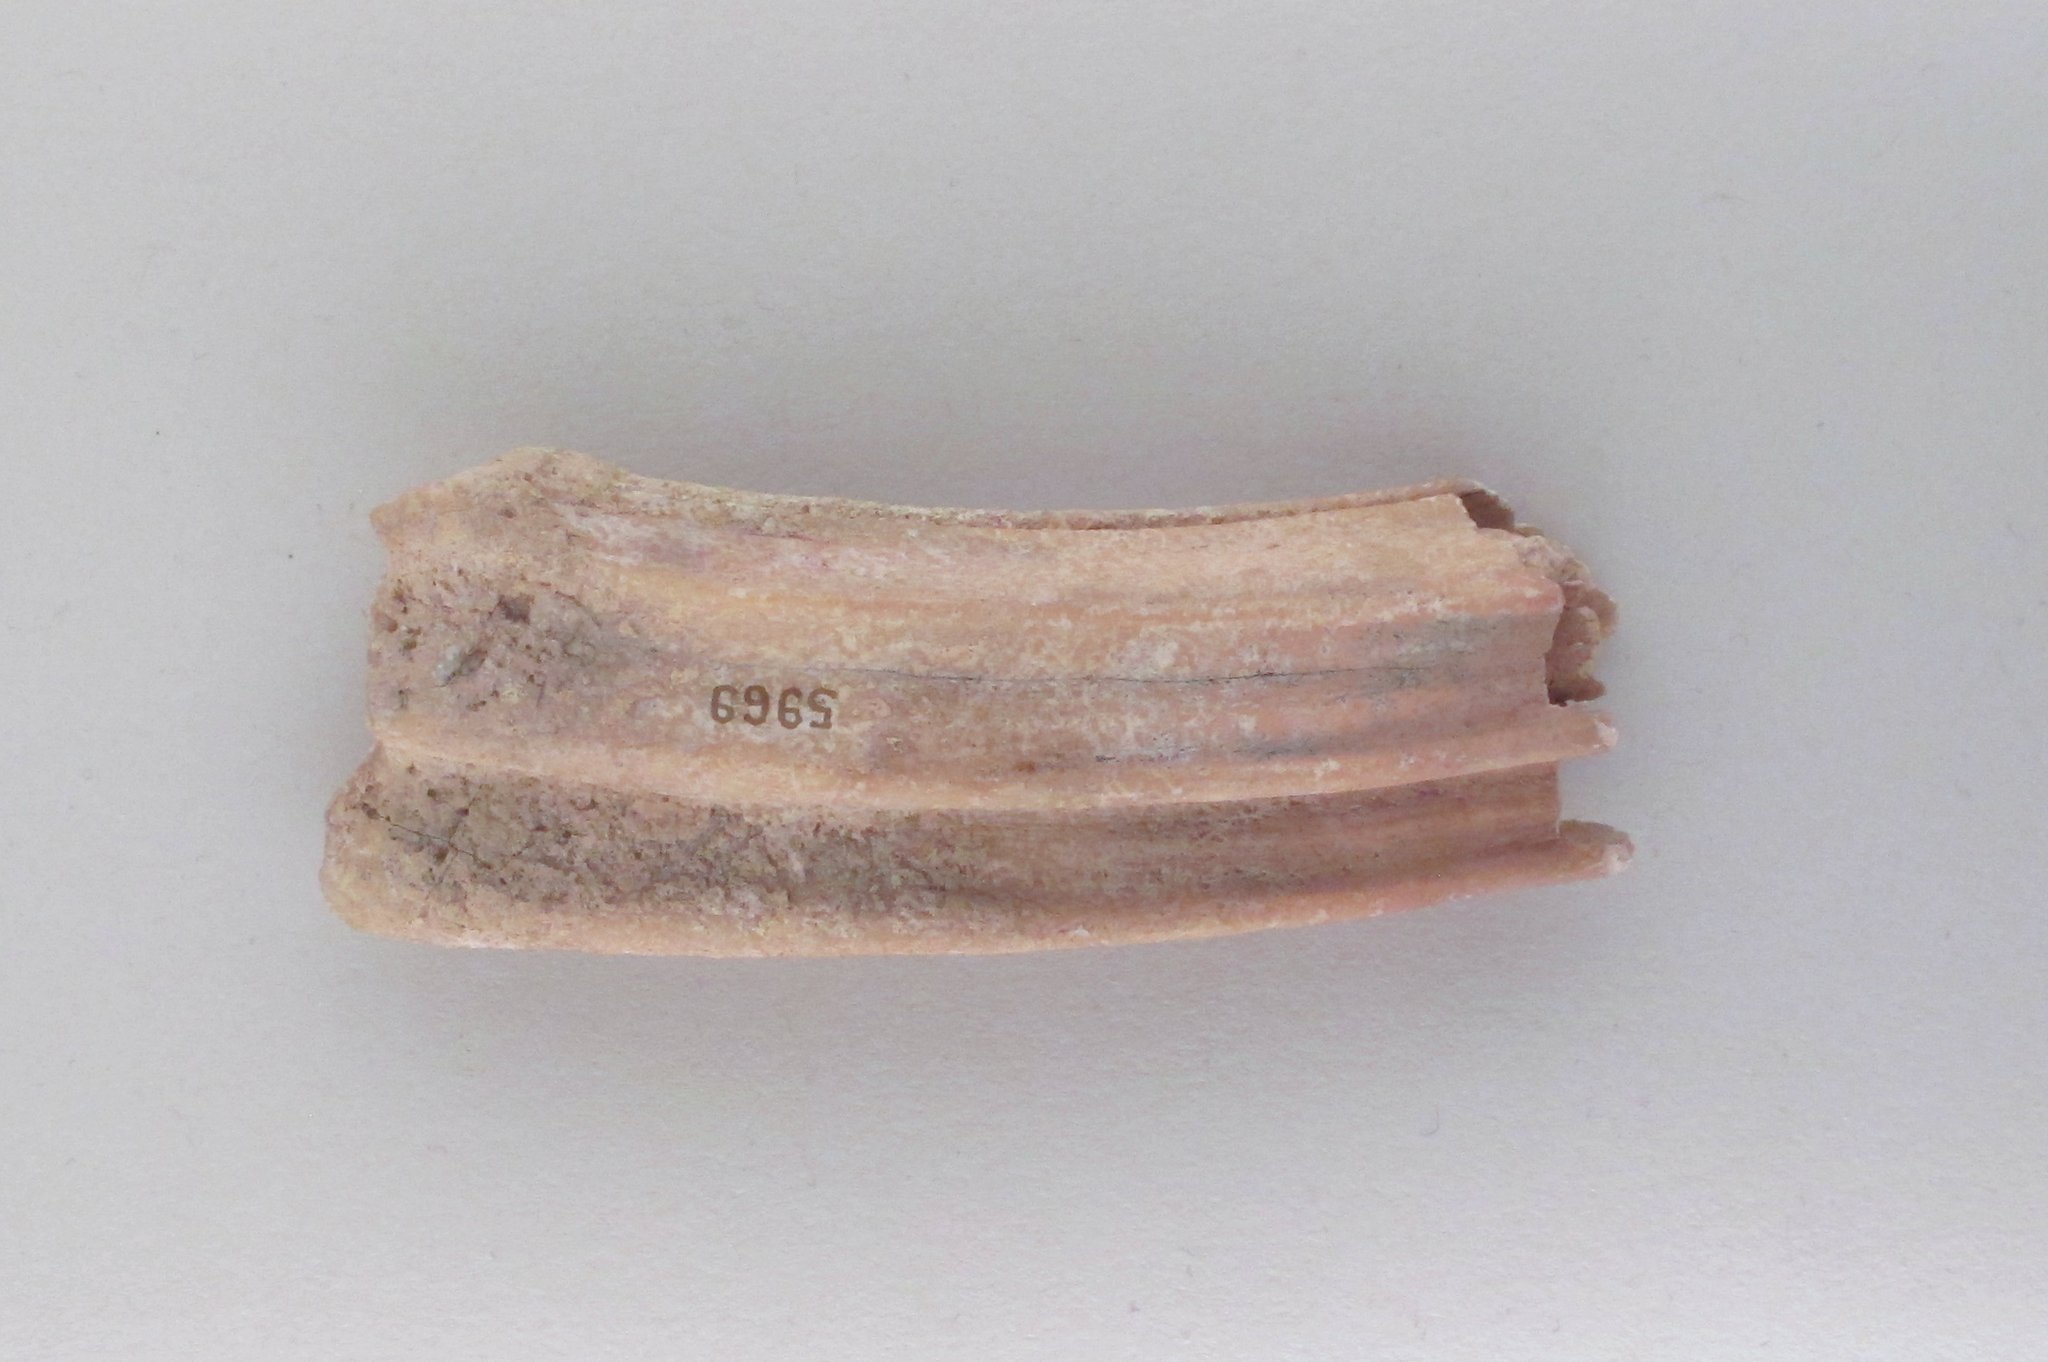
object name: tooth of an ox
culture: cypriot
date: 3900 BCE-100 CE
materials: bone